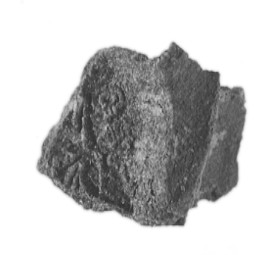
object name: sealing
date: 2030-1640 BCE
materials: clay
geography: egypt